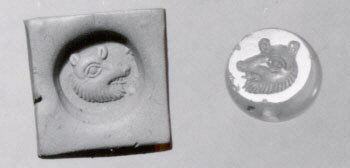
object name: stamp seal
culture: sasanian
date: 201-700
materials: quartz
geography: iran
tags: animals